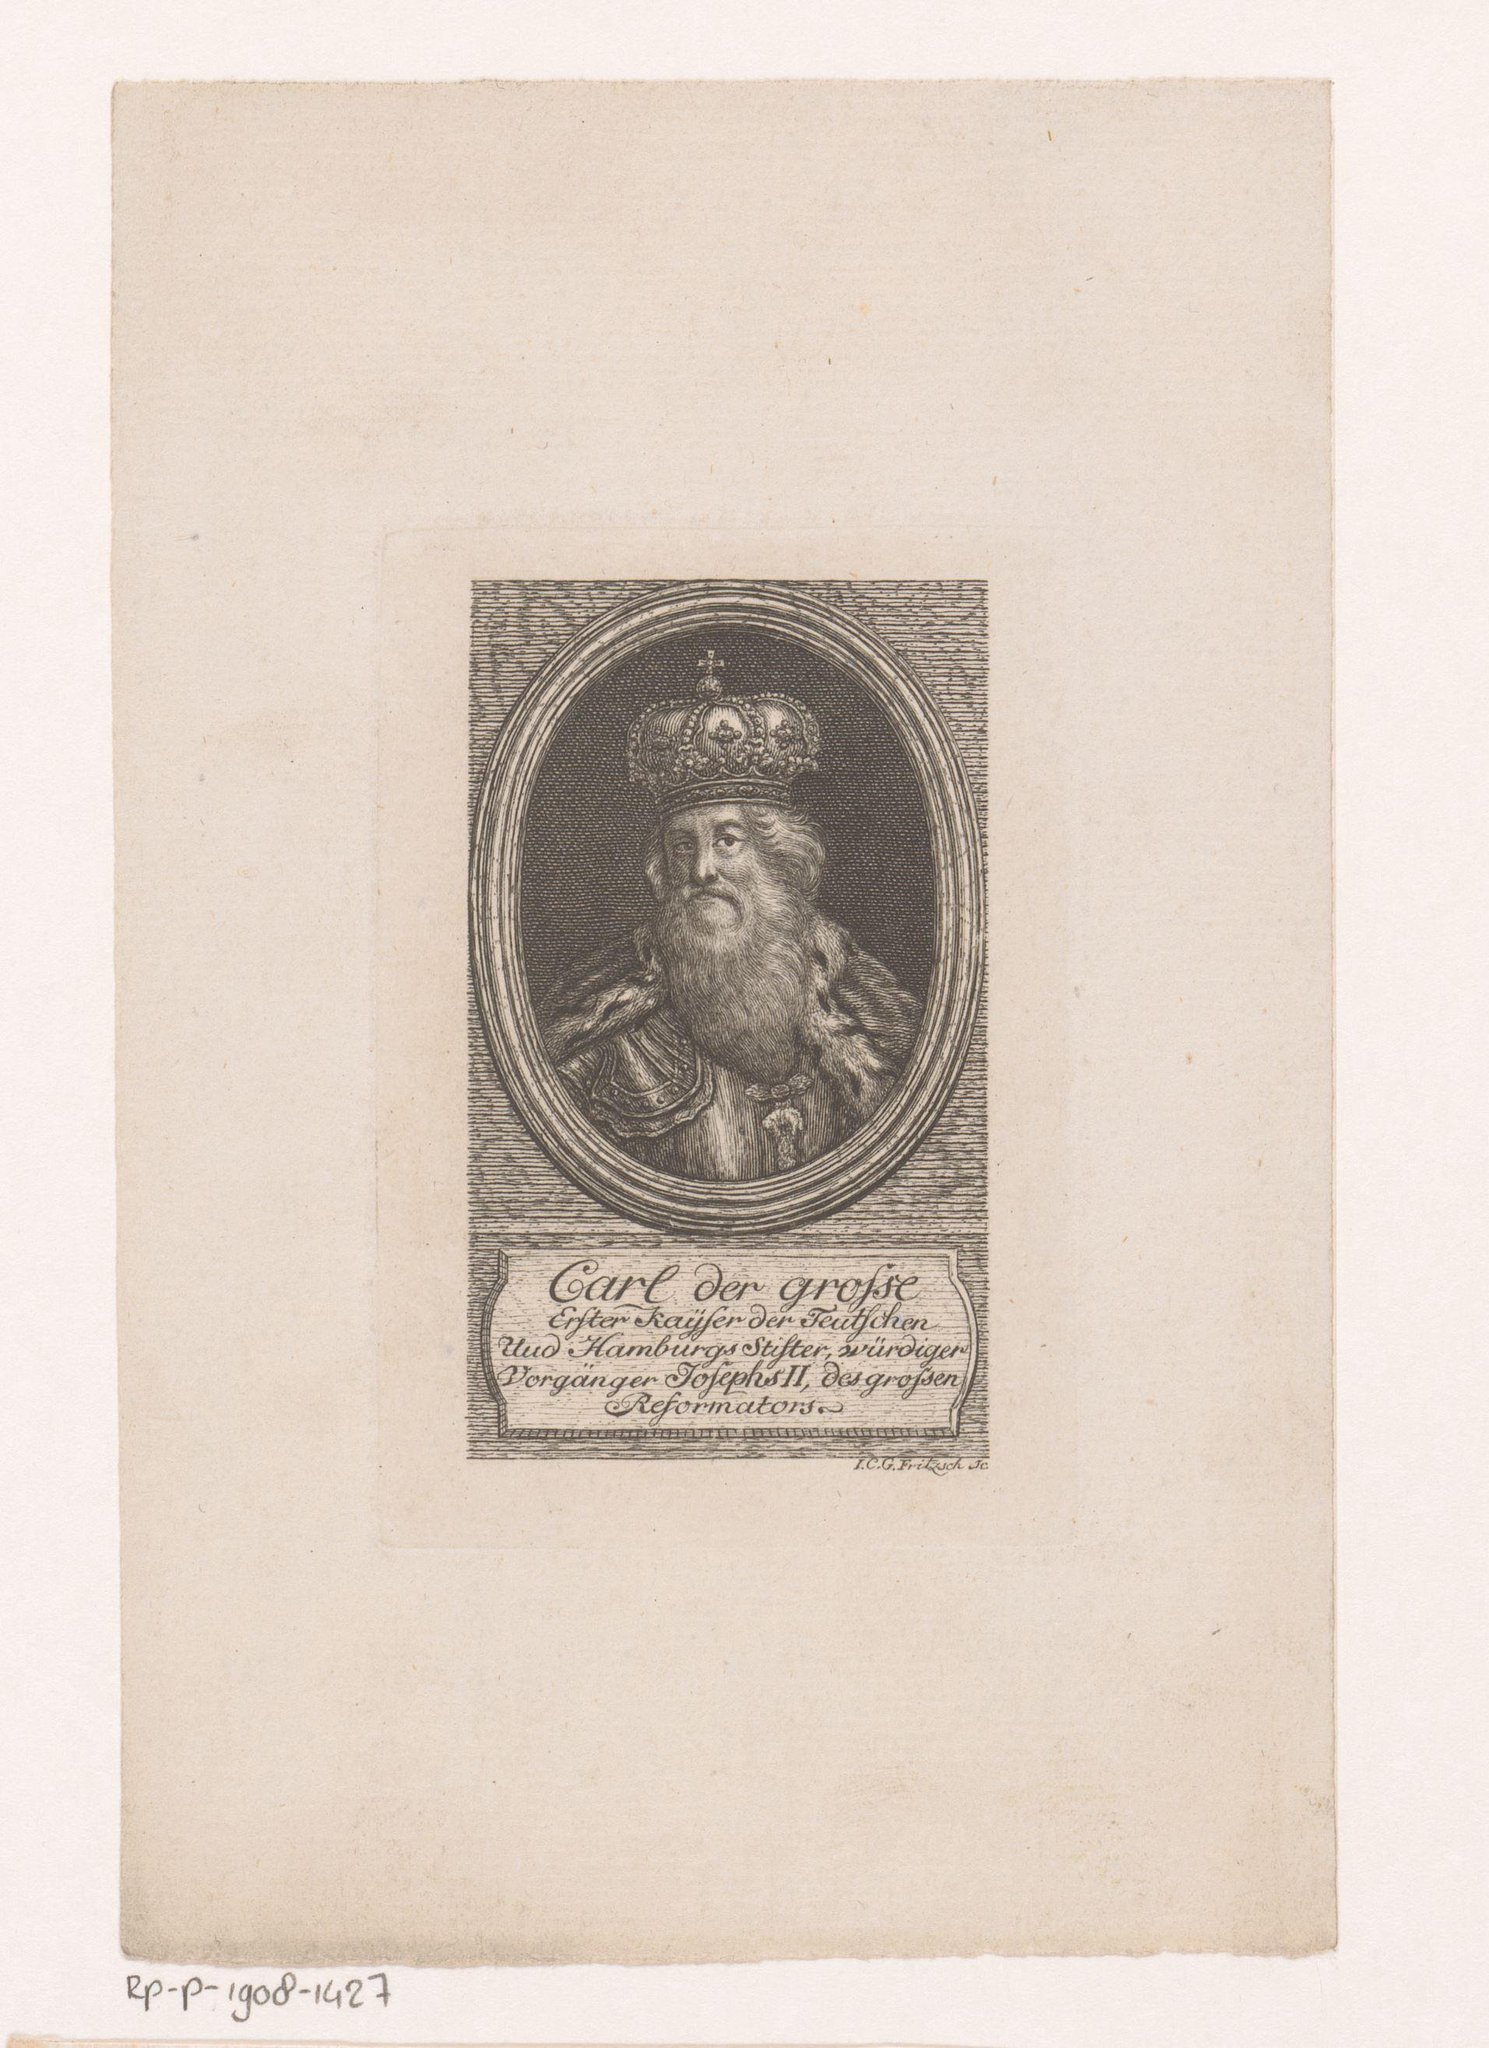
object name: print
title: Portret van Karel de Grote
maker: johann christian gottfried fritzsch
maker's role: print maker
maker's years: 1720-1802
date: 1730-1802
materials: paper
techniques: engraving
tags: charlemagne (holy roman emperor), crown (symbol of sovereignty), historical persons, ruler, sovereign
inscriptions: collector's mark: Lugt 2228